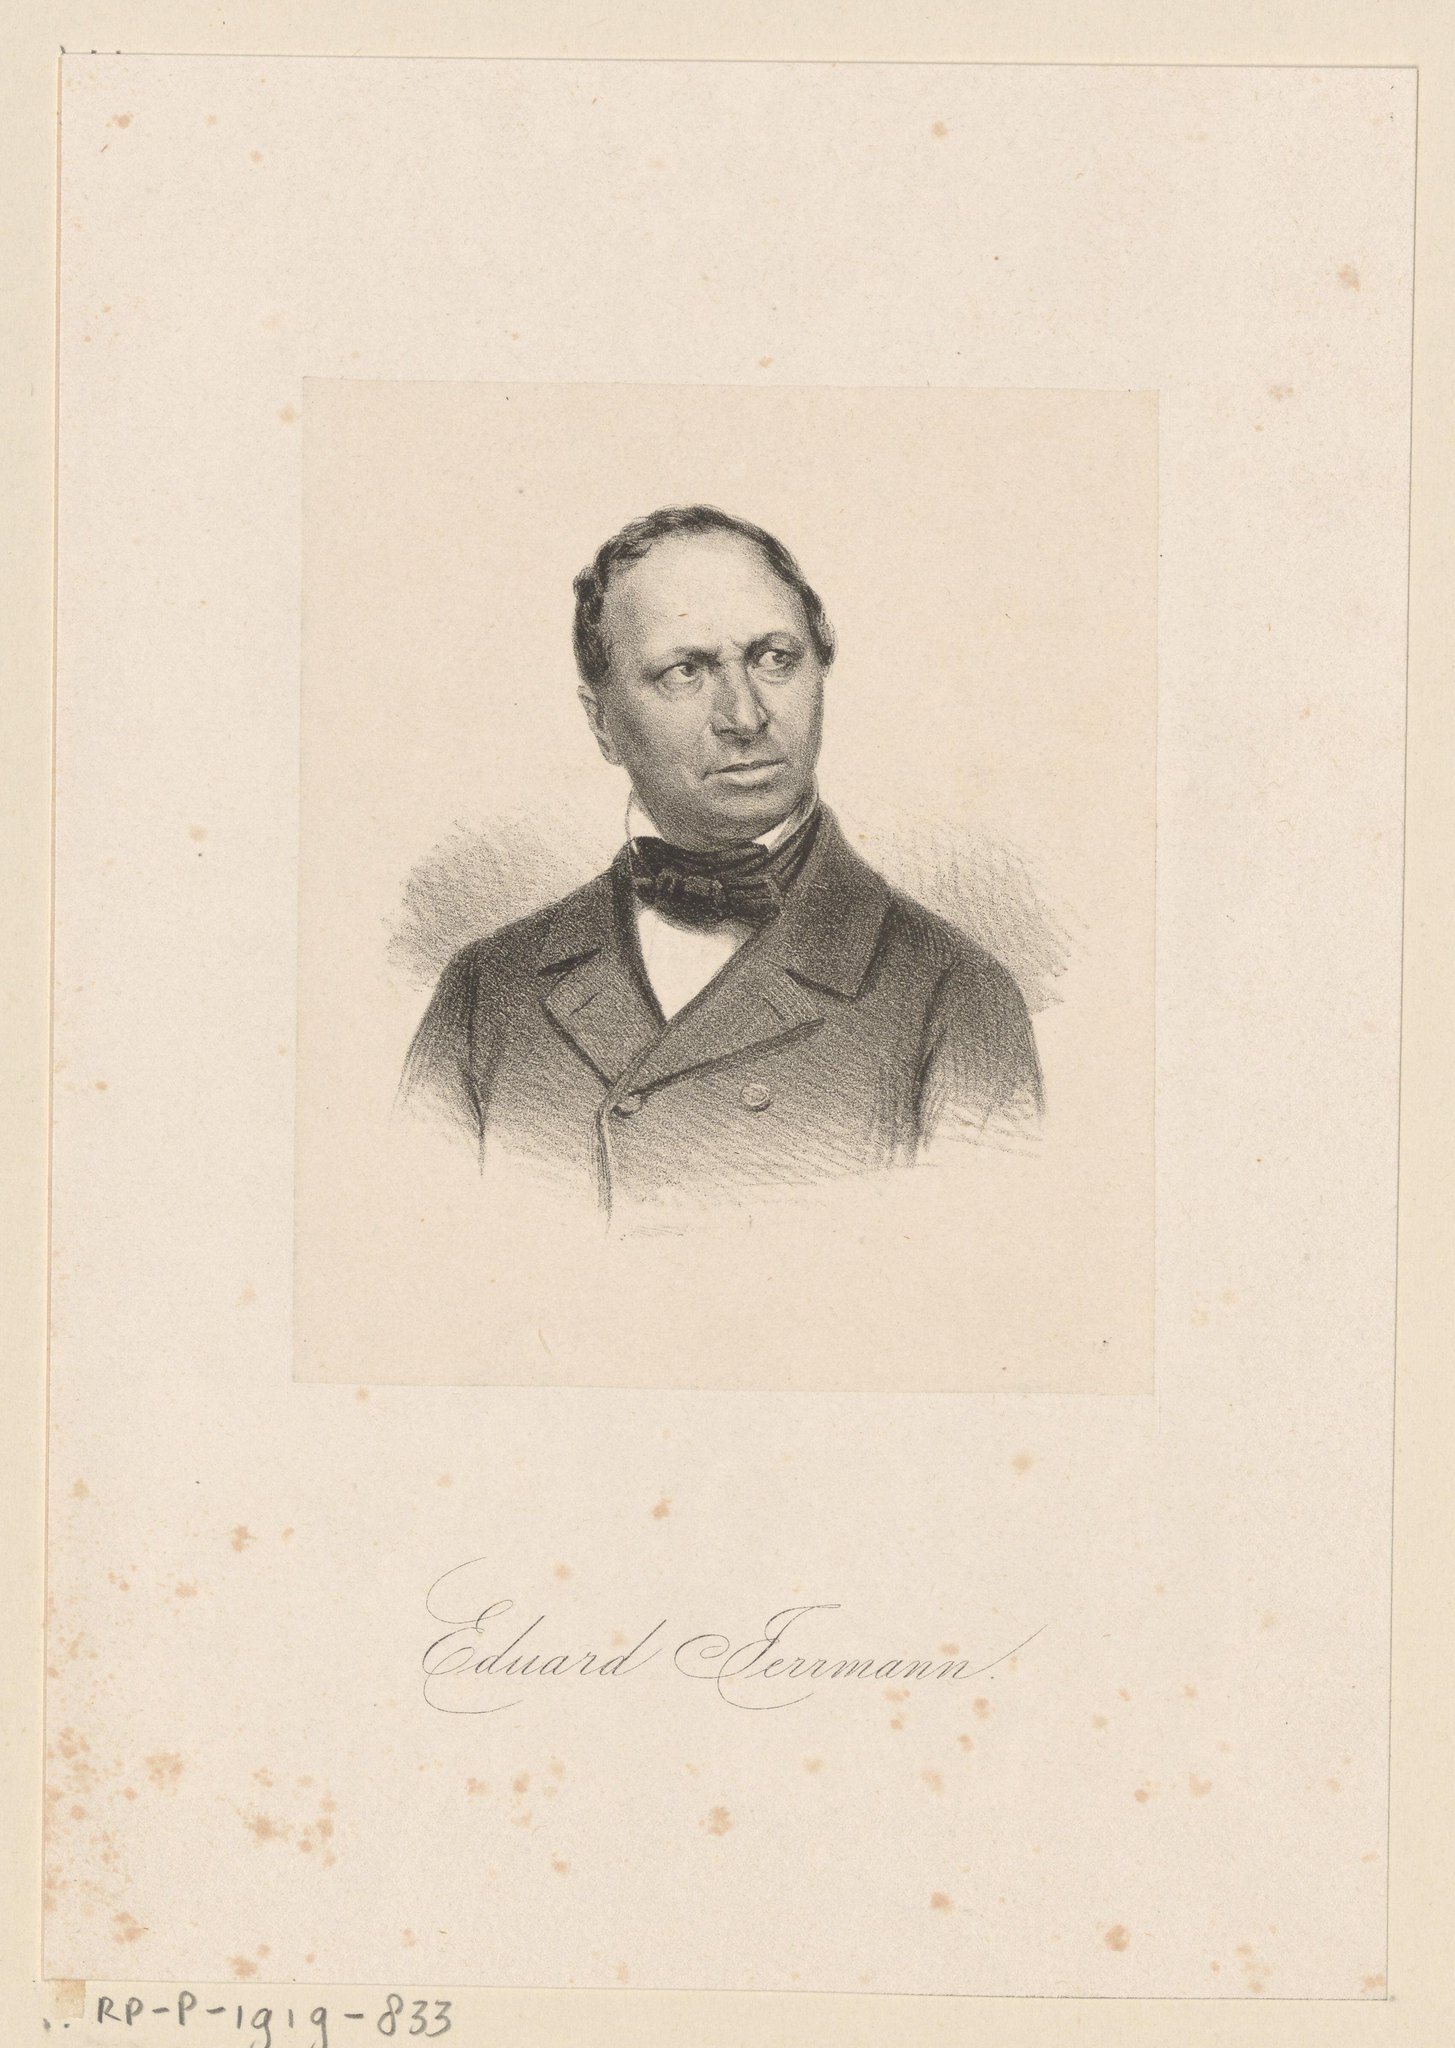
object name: print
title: Portret van Eduard Jerrmann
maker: Anonymous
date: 1830-1899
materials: paper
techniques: lithograph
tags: berlin, historical persons, actor (on the stage)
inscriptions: collector's mark: Lugt 2228